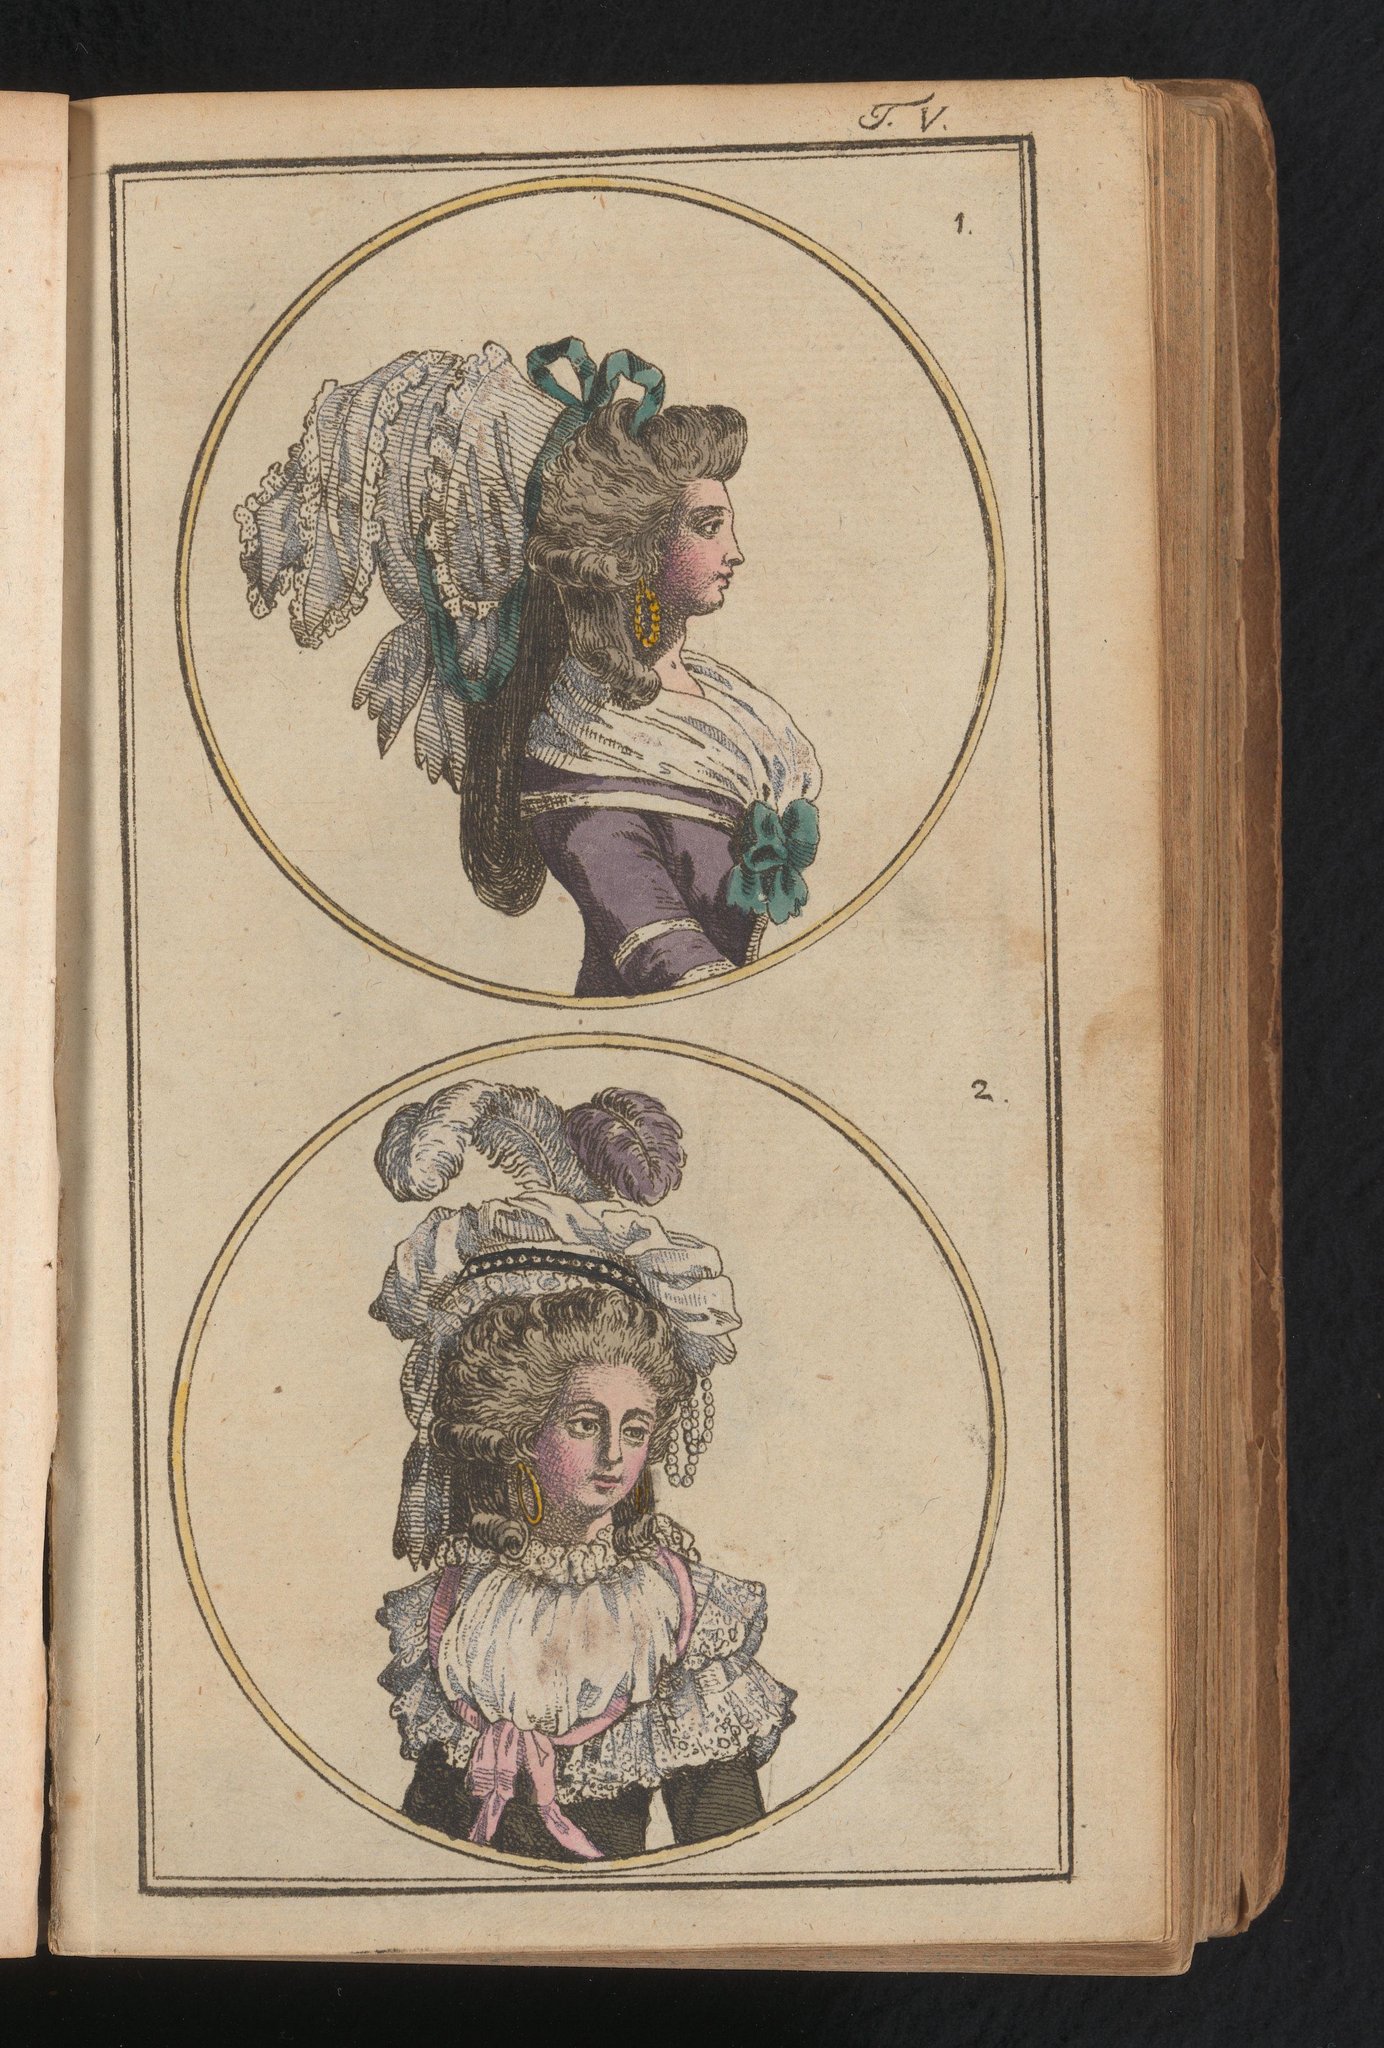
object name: magazine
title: Journal der Moden 1786. T. V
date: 1786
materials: paper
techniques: etching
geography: gotha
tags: fashion plates